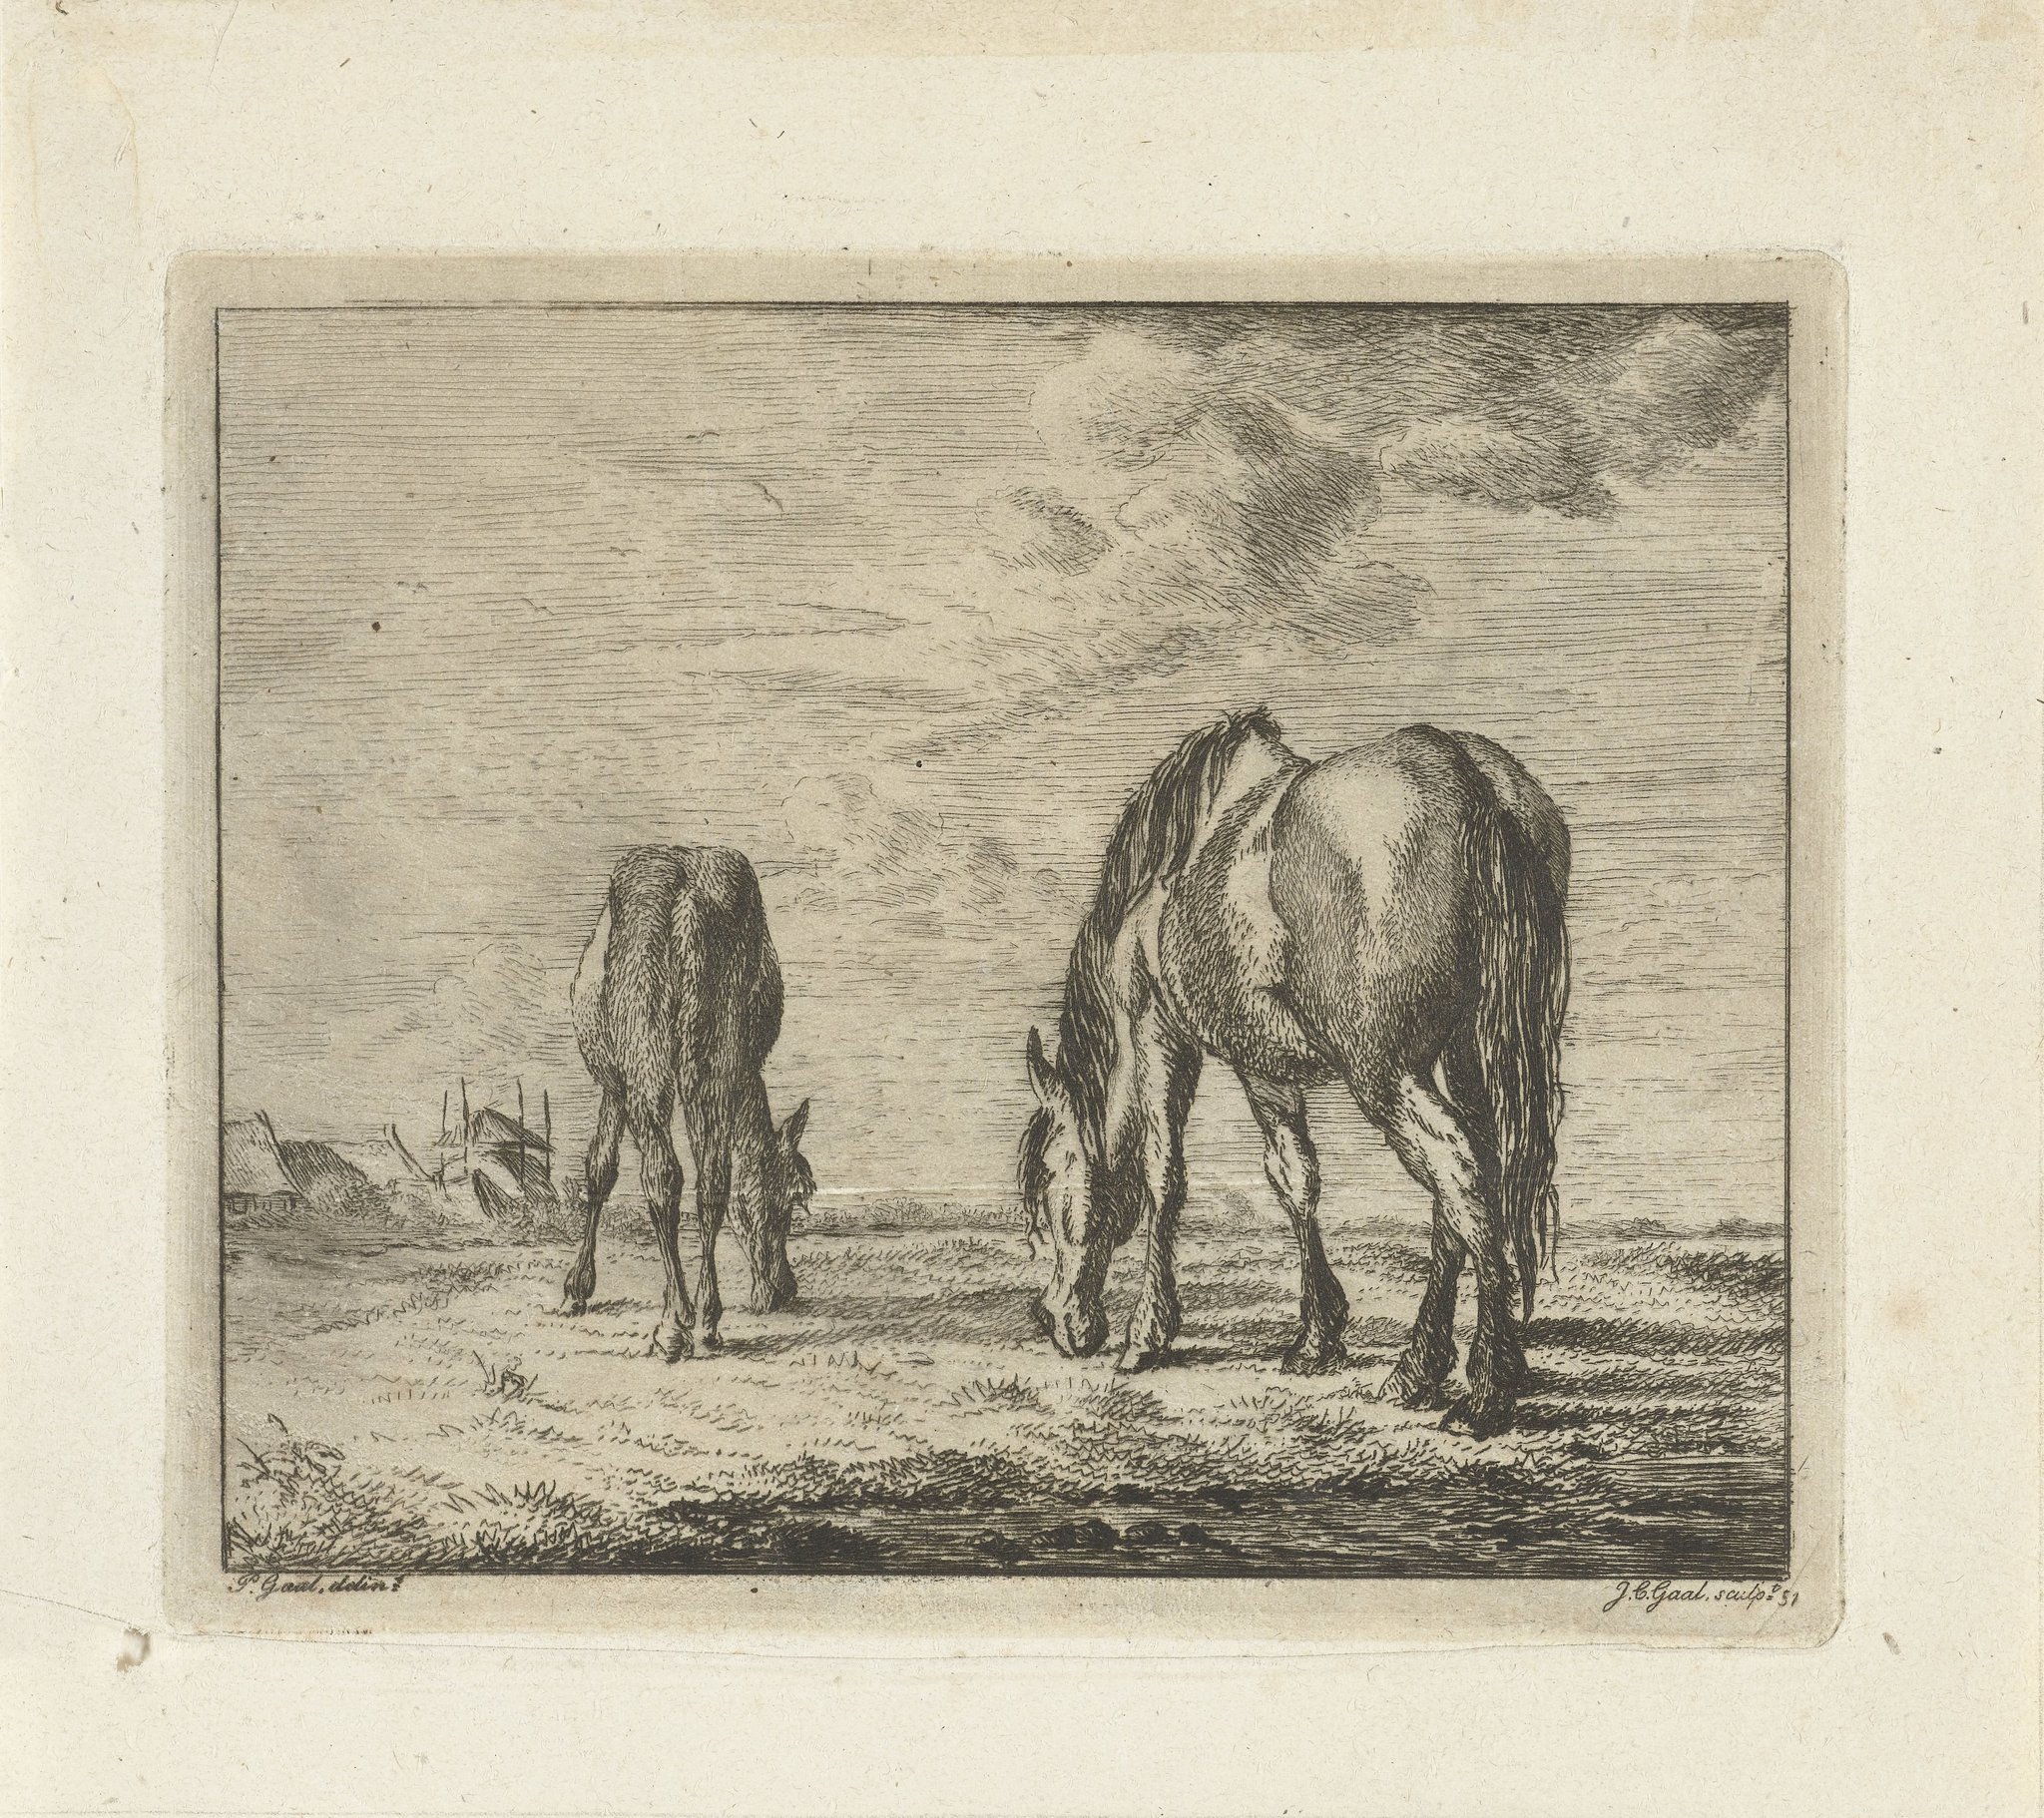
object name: print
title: Twee grazende paarden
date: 1851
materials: paper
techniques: etching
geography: netherlands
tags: horse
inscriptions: collector's mark: Lugt 2228